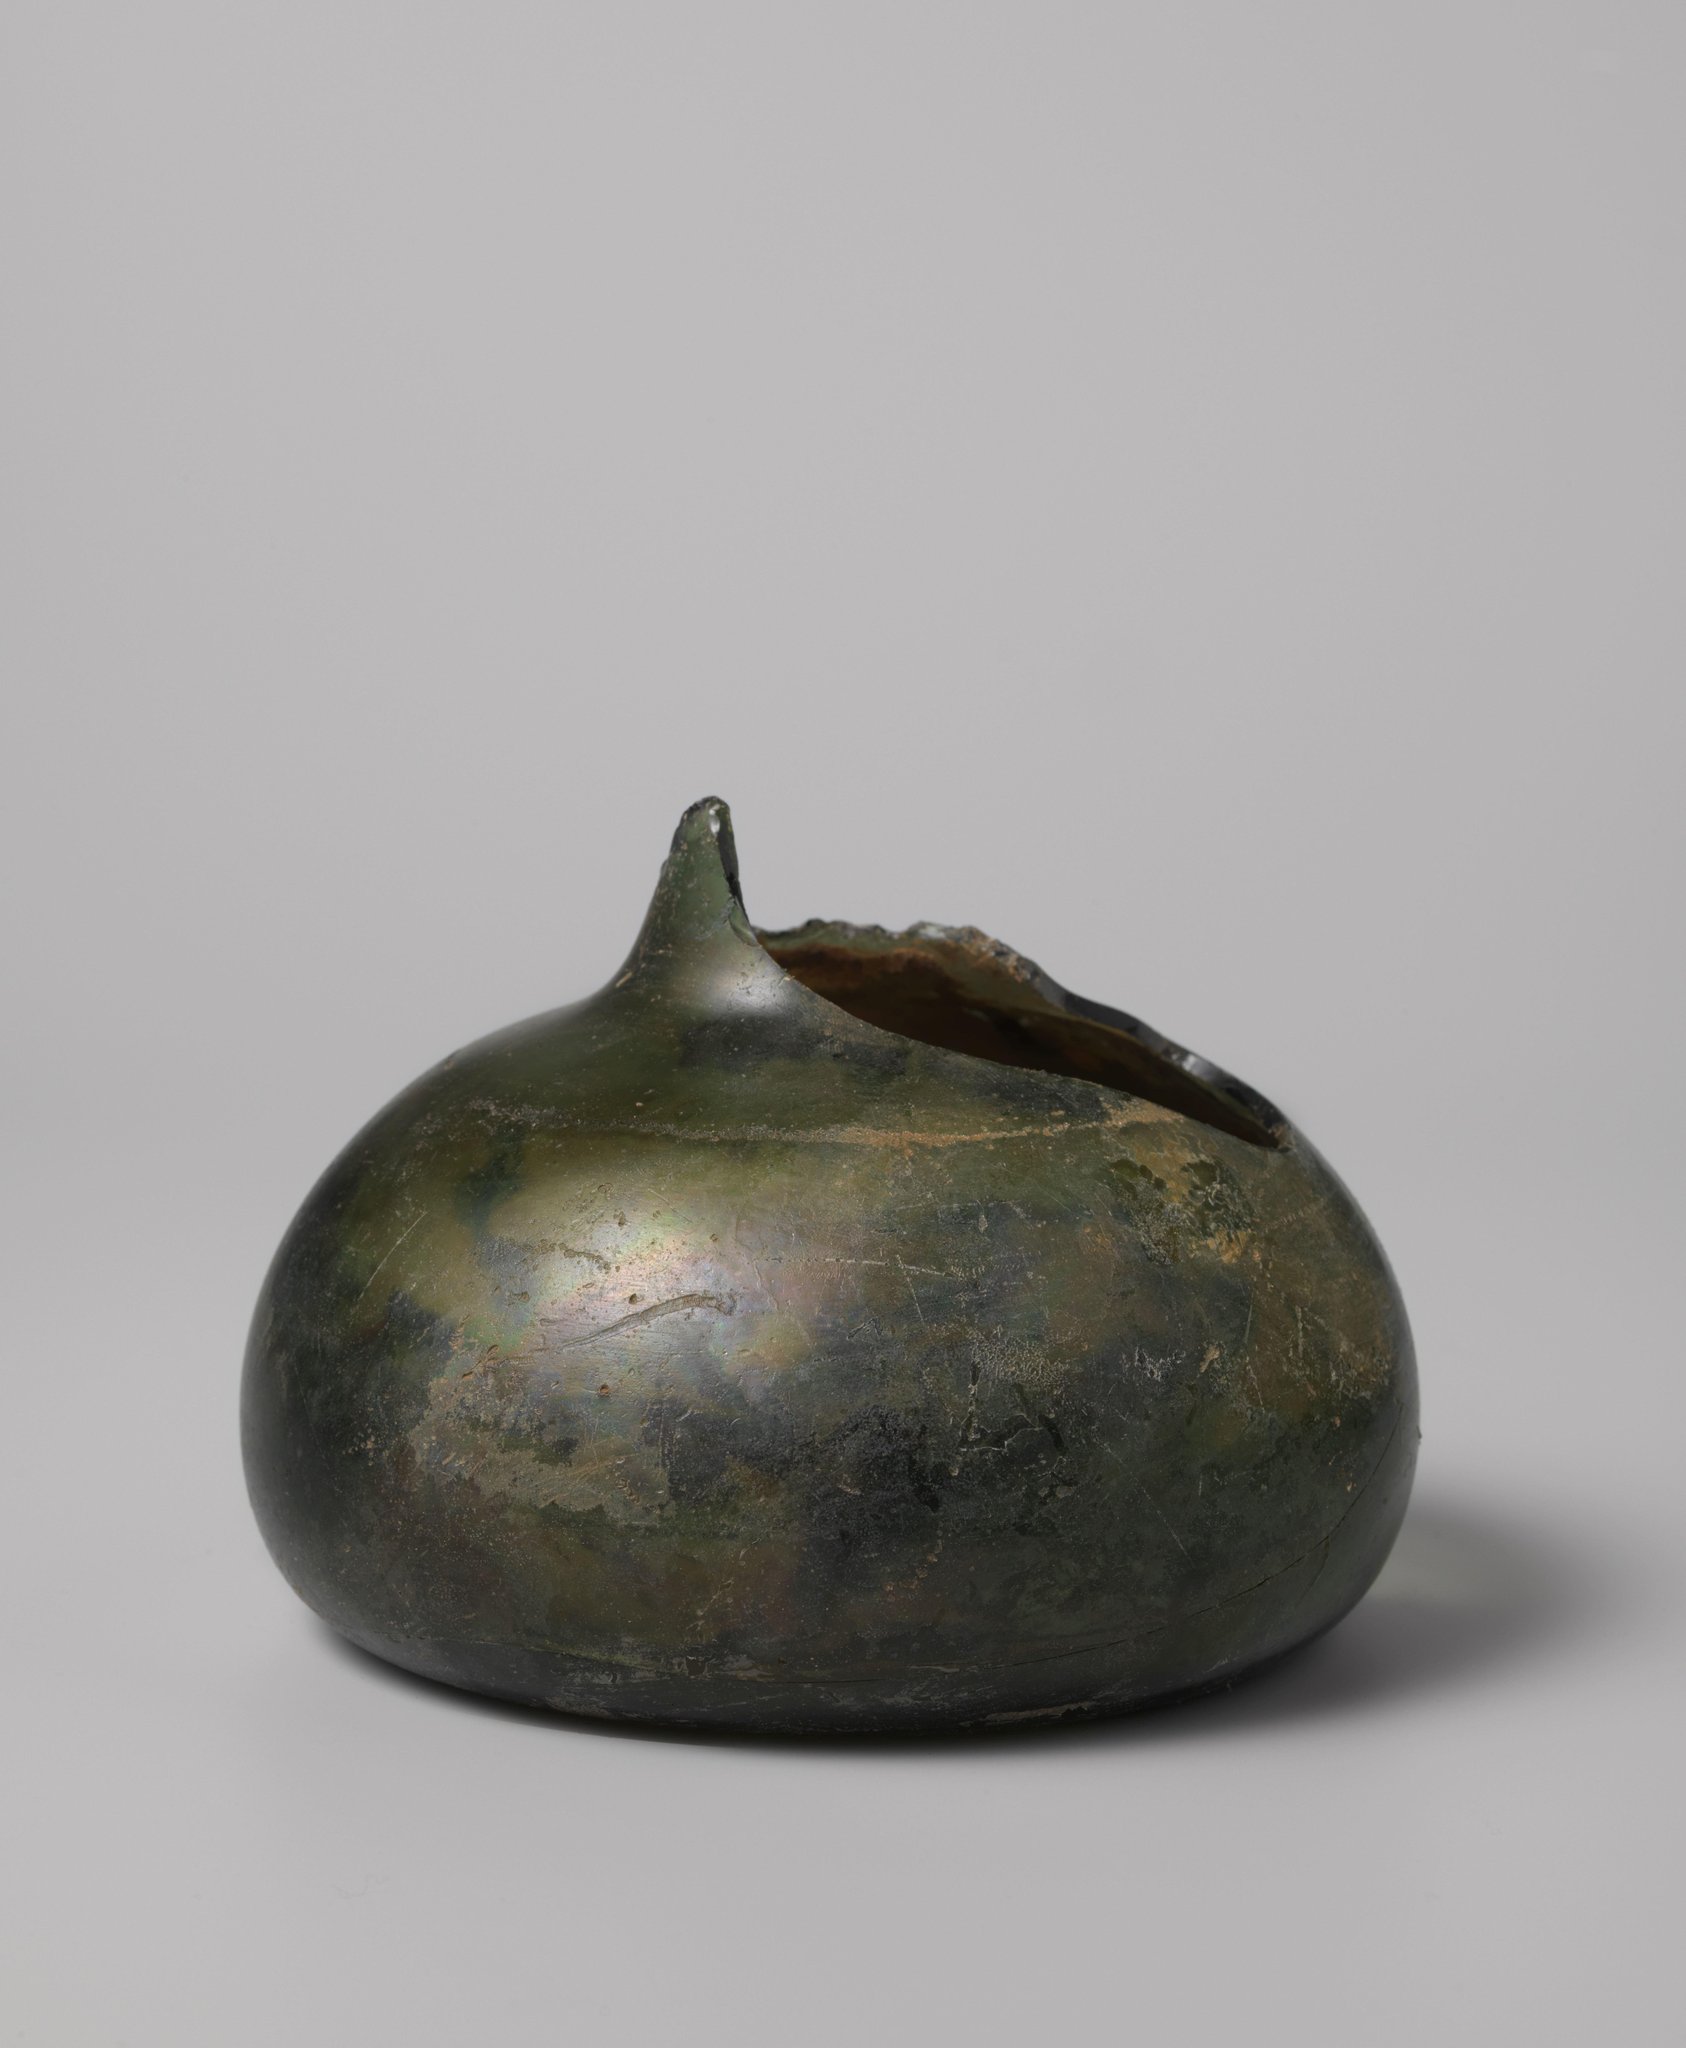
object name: wine bottle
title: Wijnfles uit het wrak van de Oost-Indiëvaarder Hollandia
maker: Anonymous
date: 1700-1743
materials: glass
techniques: green glass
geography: netherlands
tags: verenigde oostindische compagnie, hollandia (schip), annet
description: Wine bottle, continental production, onion-shaped, mouth missing; (1) (11h, belly 16d, base 12d), cs-kick-up.